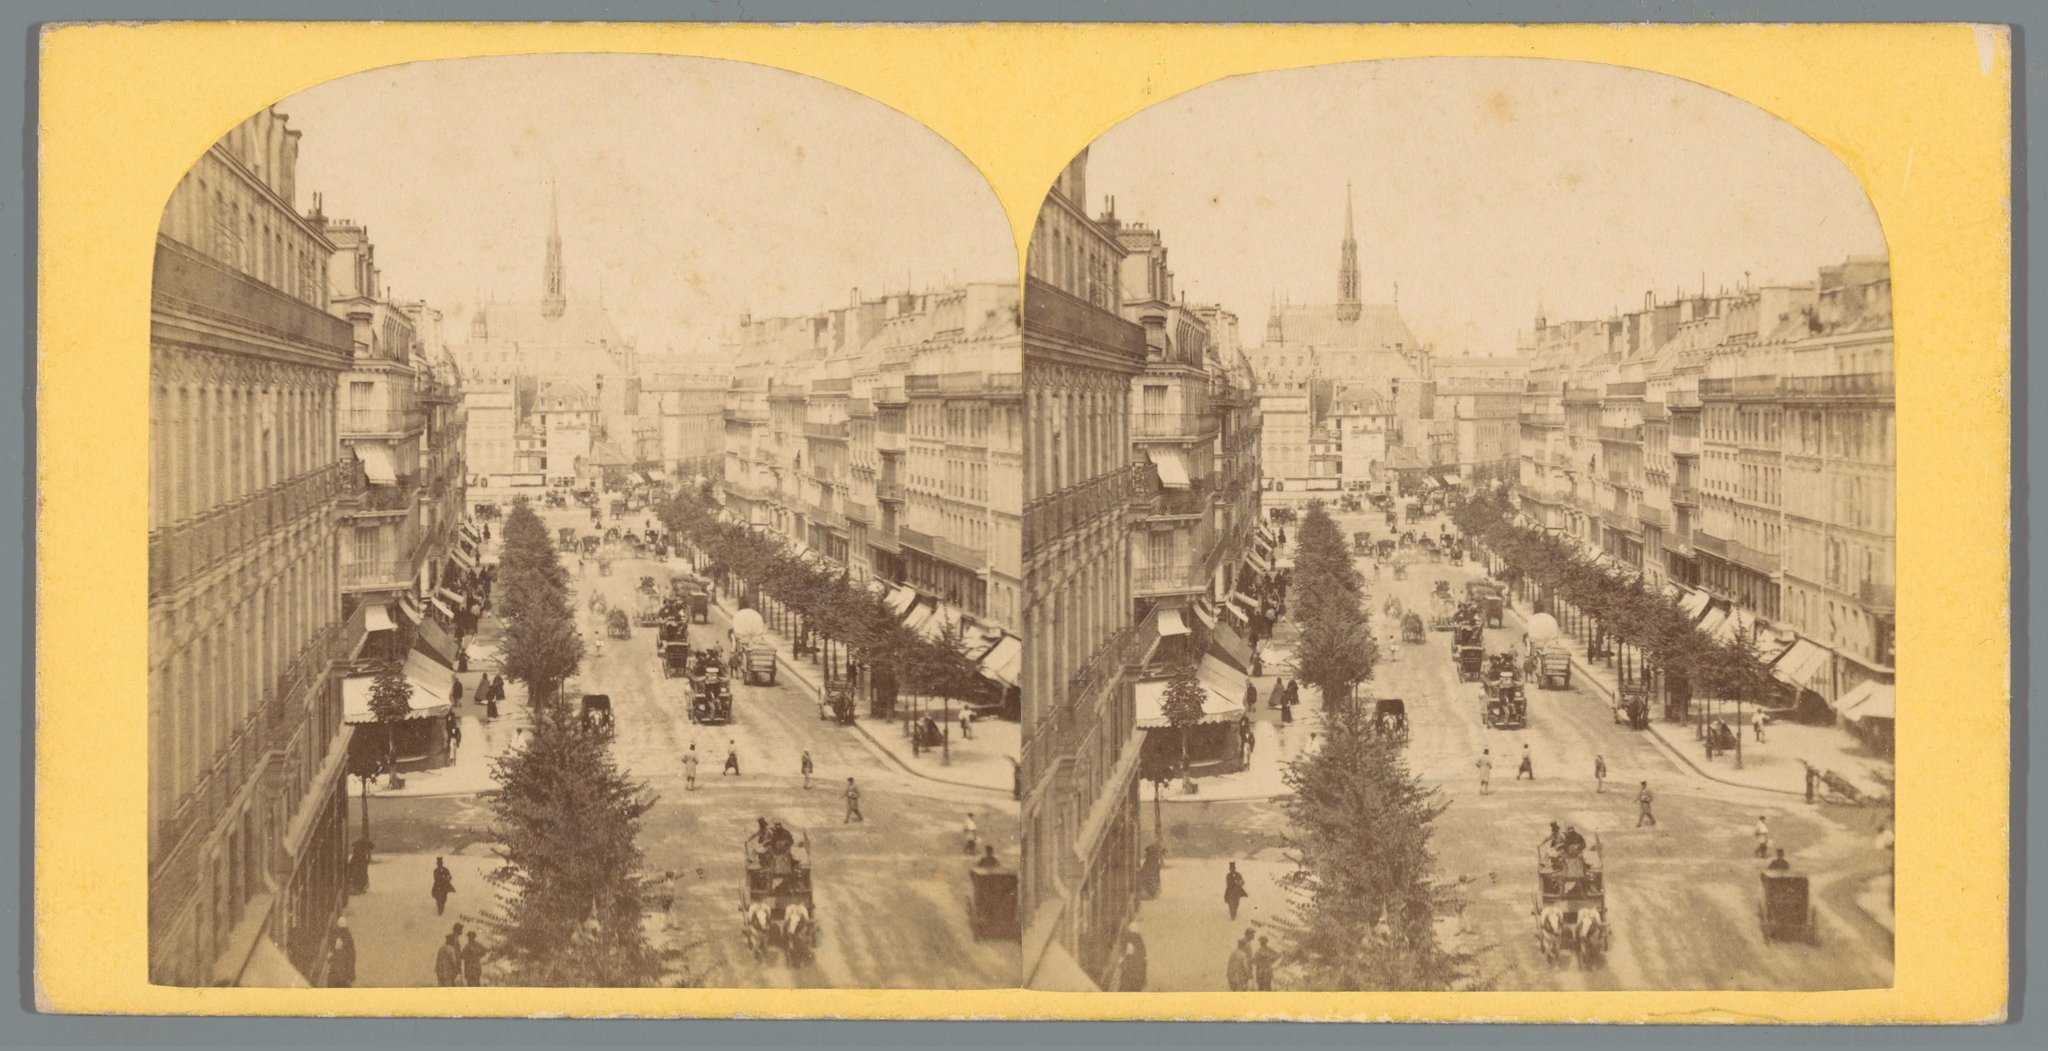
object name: stereograph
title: Boulevart de Sébastopol (Rive gauche)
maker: Anonymous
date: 1850-1880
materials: cardboard, photographic support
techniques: albumen print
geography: paris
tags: animal traction, animal-drawn vehicle (carriage etc.), street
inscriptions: number: ‘No. 43’